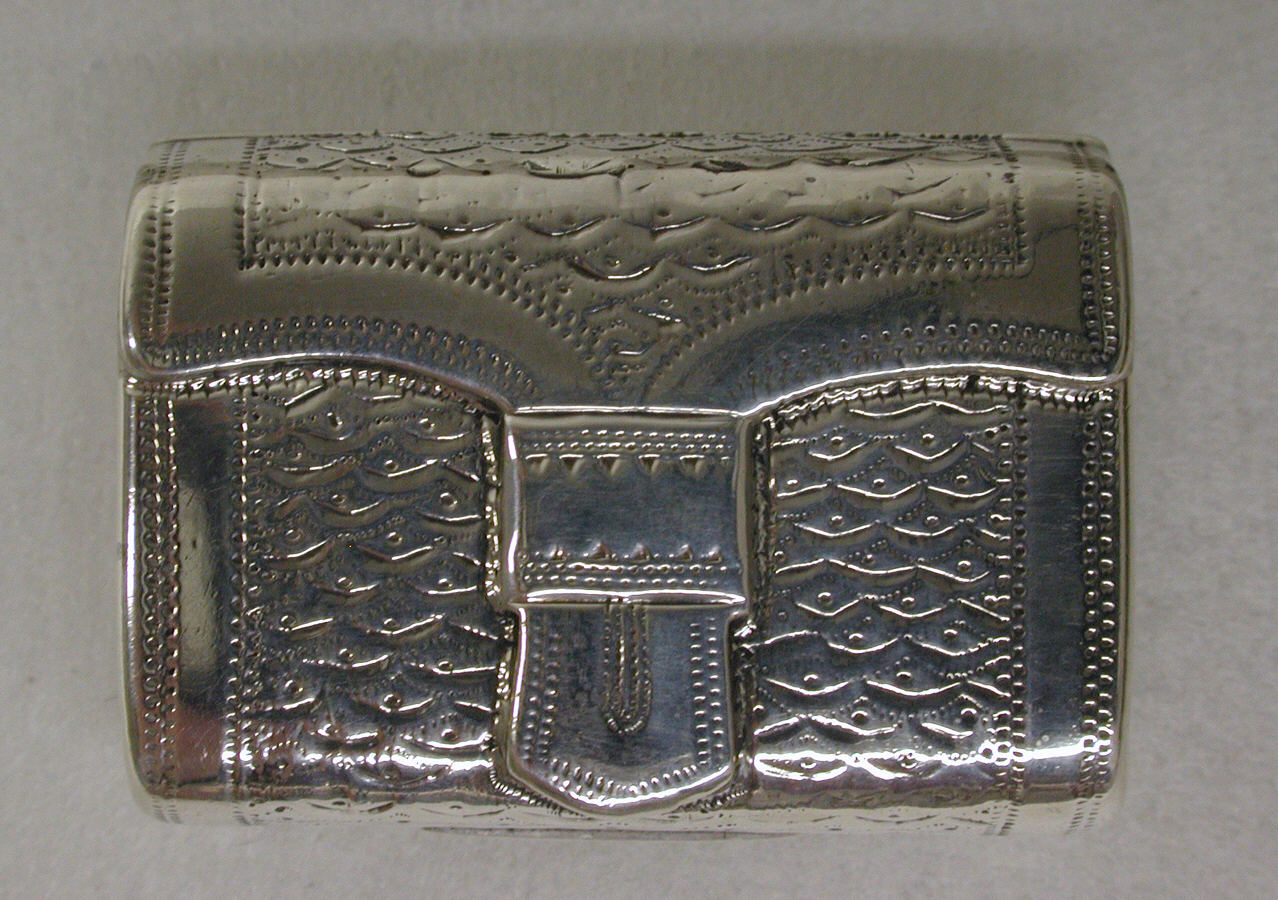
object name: vinaigrette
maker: joseph willmore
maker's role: maker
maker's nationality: british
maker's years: 1773-1855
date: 1819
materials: silver